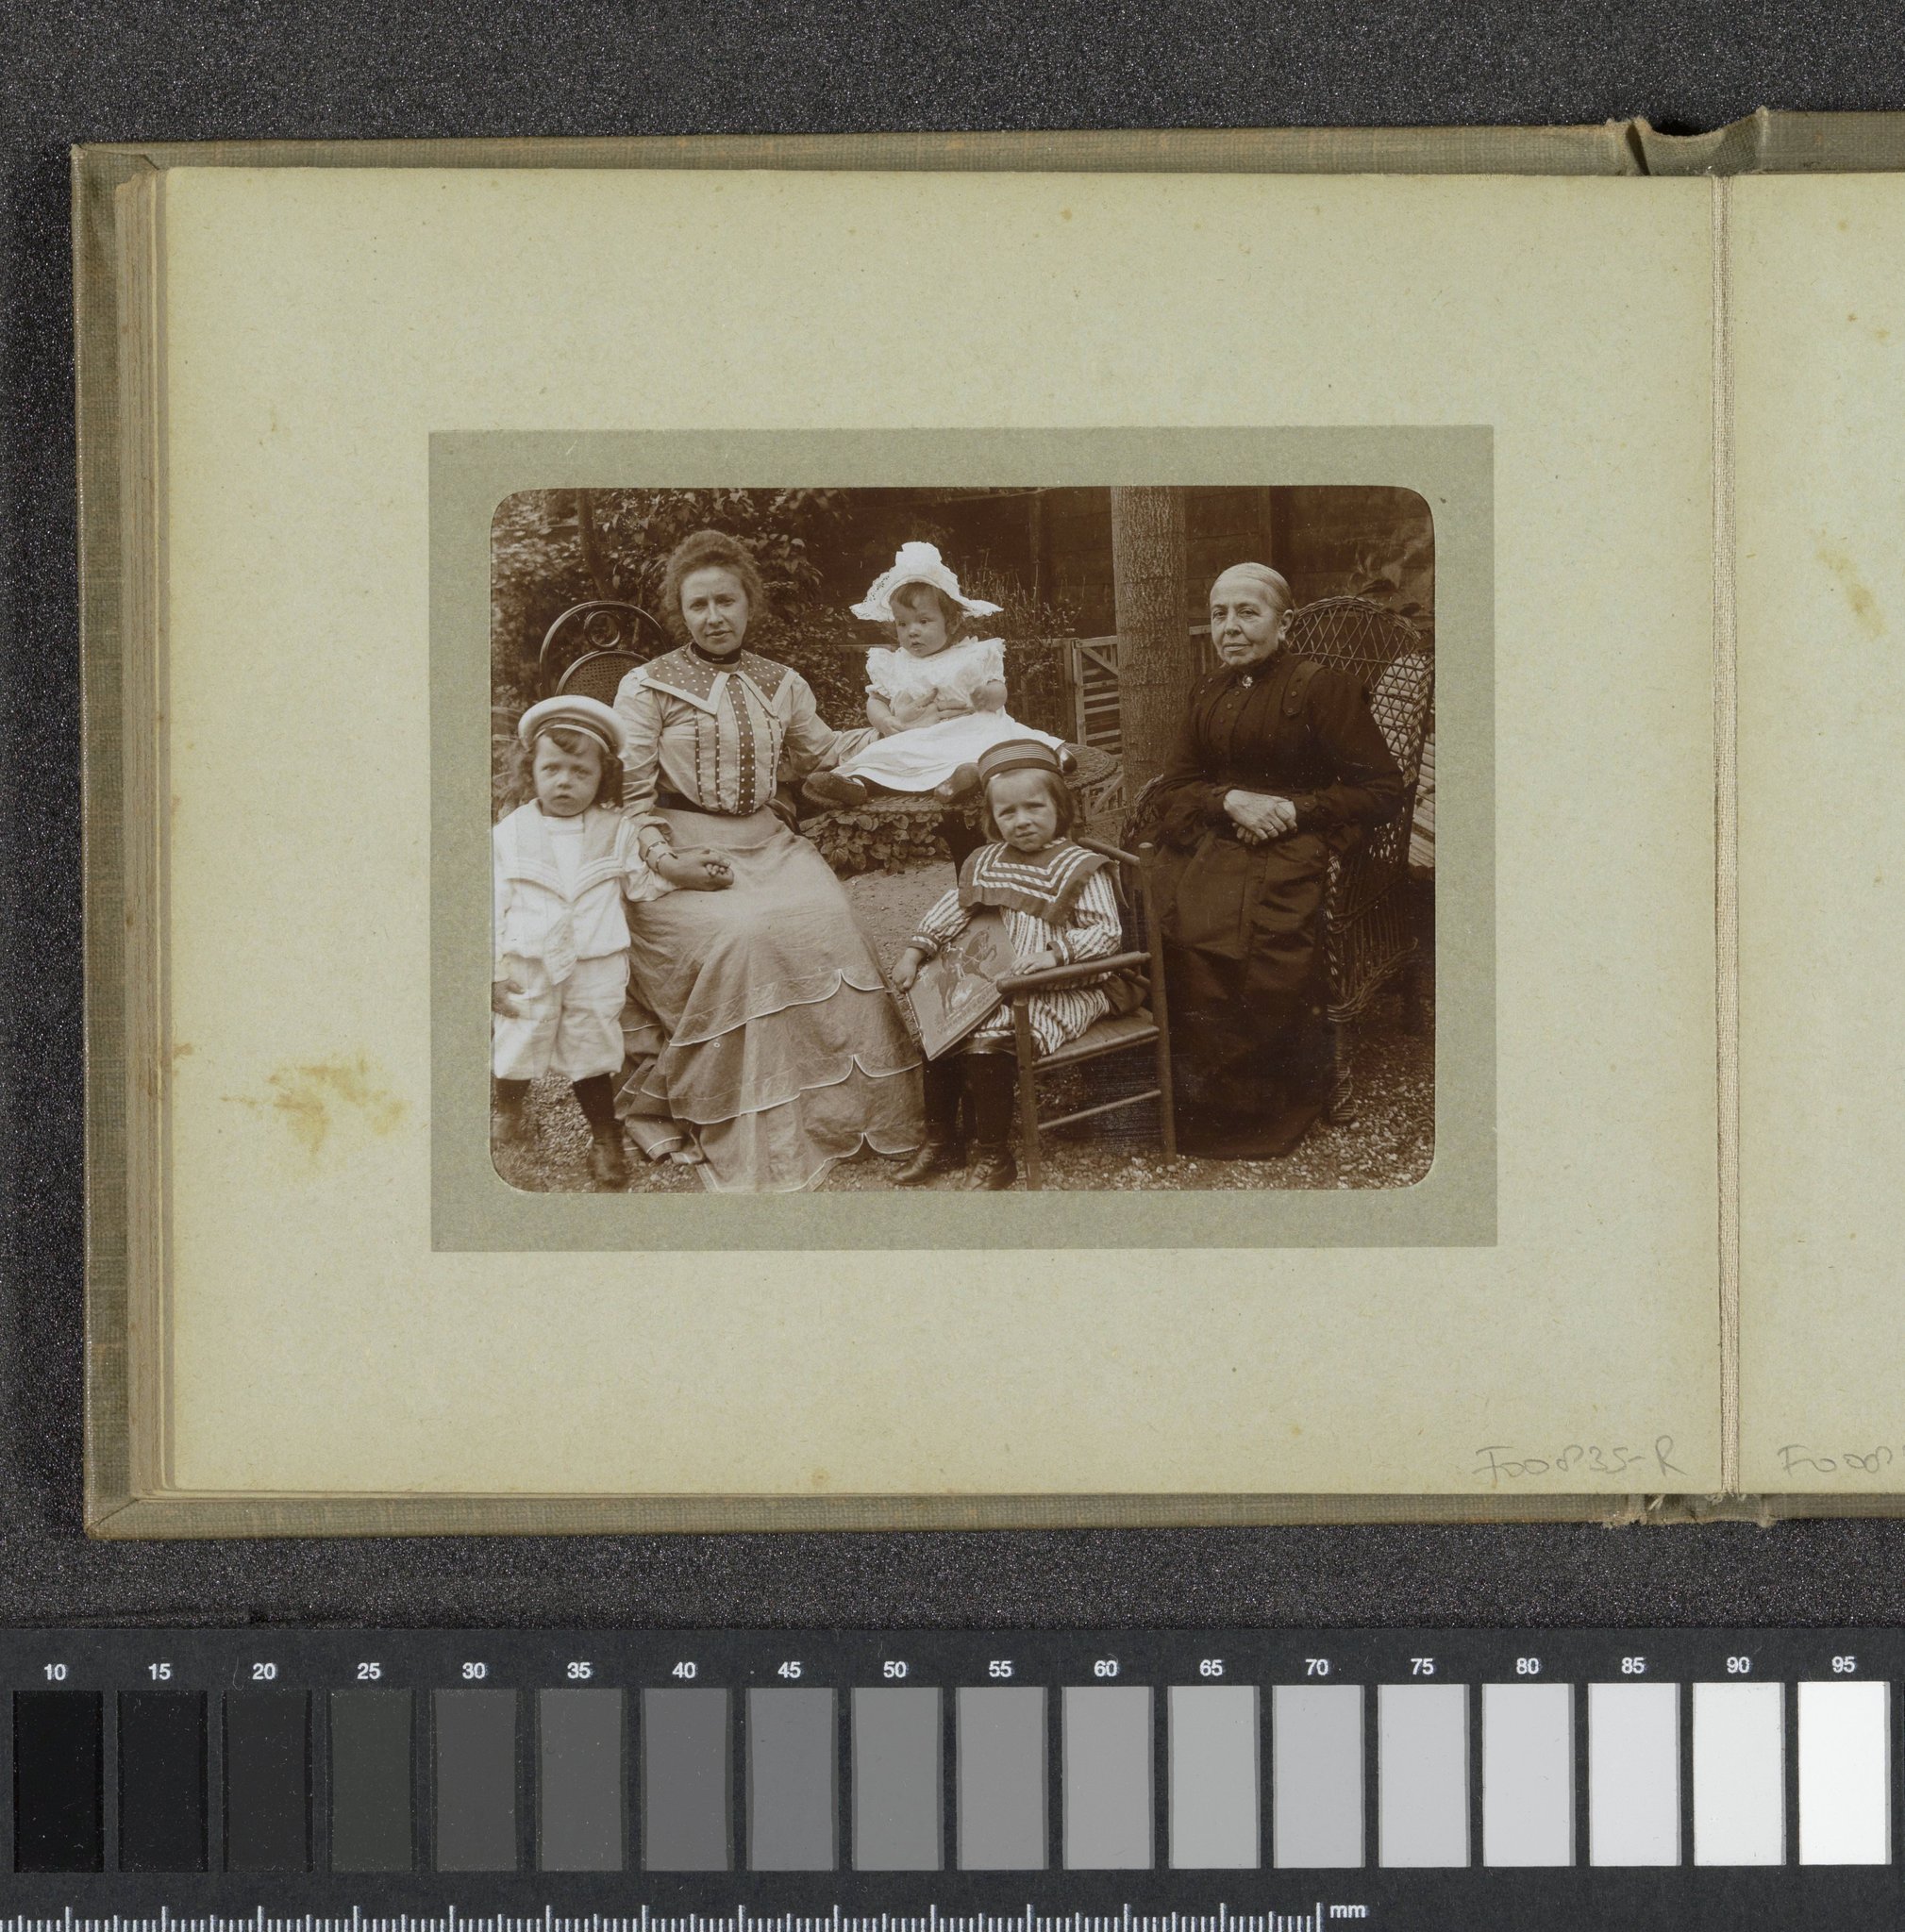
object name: photograph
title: Twee vrouwen en drie kleuters in een tuin, waarschijnlijk de tweeling Ad (staand) en Johanna (met plaatjesboek van Verkade & Comp.), Han (met zonnehoed) van der Kop, hun moeder W.G. Hoogendijk en een familielid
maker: willem carel van der kop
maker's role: amateurfotograaf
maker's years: 1869-1924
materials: cardboard, paper, photographic support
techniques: collodion silver print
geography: schoonhoven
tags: twins, head-gear: hat, family life, reading a picture book, mother and baby or young child, infant, baby, tot, toddler ~ the ages of man, three generations (family group), brothers or sisters (second degree family relationships)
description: Onderdeel van Fotoalbum met opnames van Ad, Johanna en Han van der Kop, hun moeder W.G. Hoogendijk en familieleden.